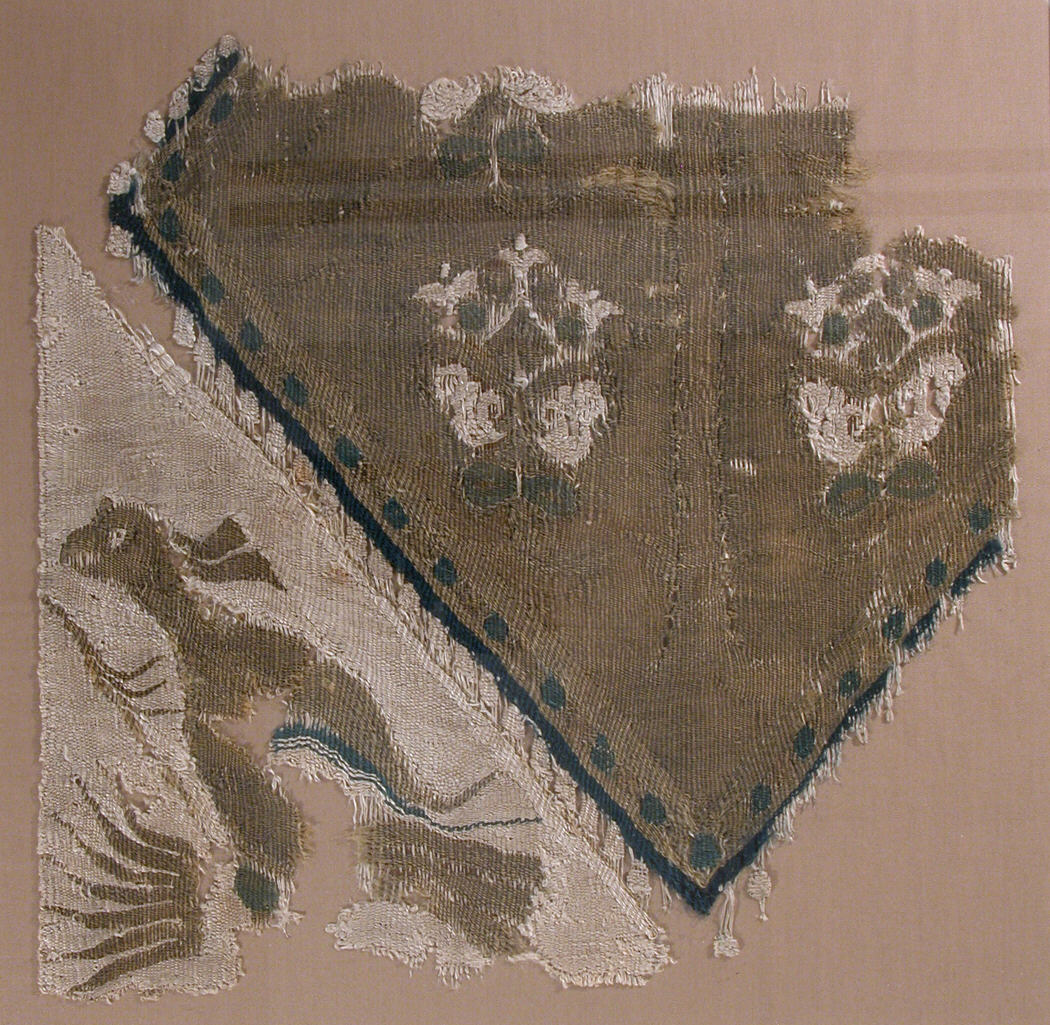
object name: textile fragment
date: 801-1000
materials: linen, wool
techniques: weave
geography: egypt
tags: birds